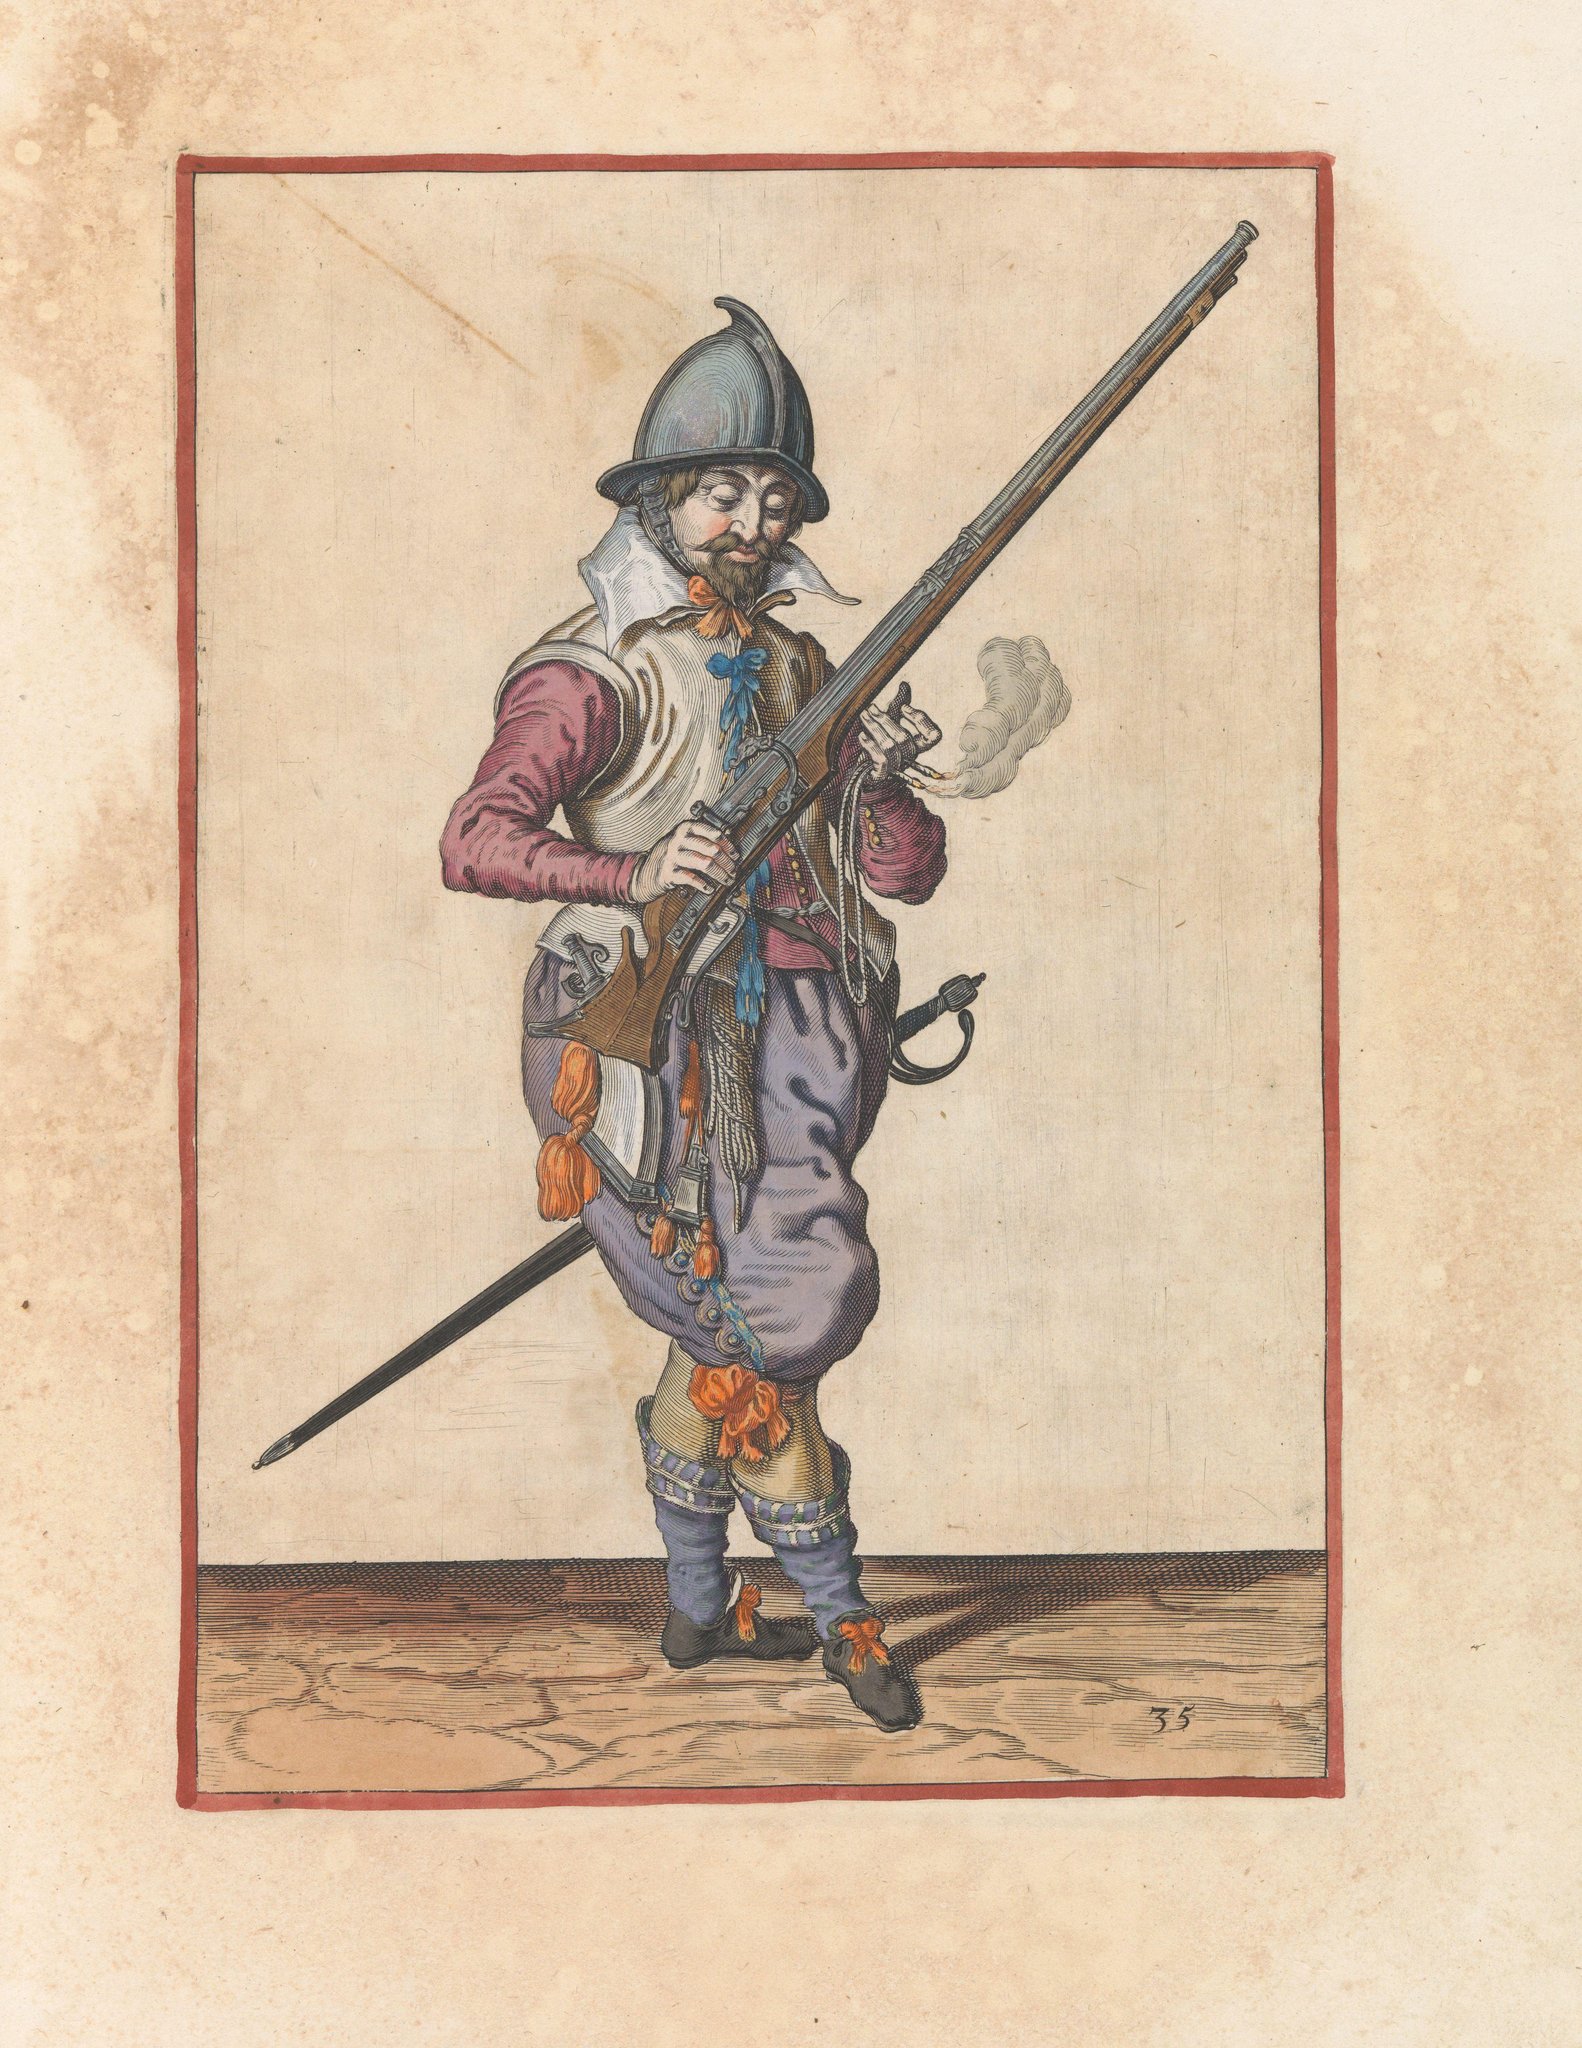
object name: print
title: Corte onderwysinghe op de figuerliicke afbeeldinghe, belanghende t'rechte ghebruyck des Roers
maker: jacques de gheyn (ii)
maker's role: painter, print maker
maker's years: 1565-1629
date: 1597-1607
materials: paper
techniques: engraving, hand coloring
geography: the hague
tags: handling of weapons ~ military training, firearms: rifle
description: Een soldaat op wacht, ten voeten uit, naar rechts, die een roer (een bepaald type vuurwapen) met zijn rechterhand vasthoudt, de loop schuin omhoog gericht. Hij laat de loop juist in zijn linkerhand vallen, waarin ook een brandende lont. Deze prent is onderdeel van de reeks van 42 met de hand genummerde prenten van roerschutters in de Wapenhandelinghe. Op dit is exemplaar het nummer gedrukt.